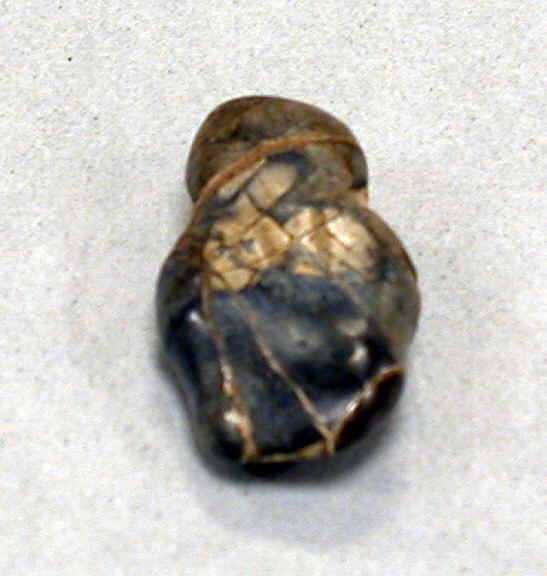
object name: pendant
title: Stone Figure Pendant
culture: costa rican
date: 801-1500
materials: stone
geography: costa rica